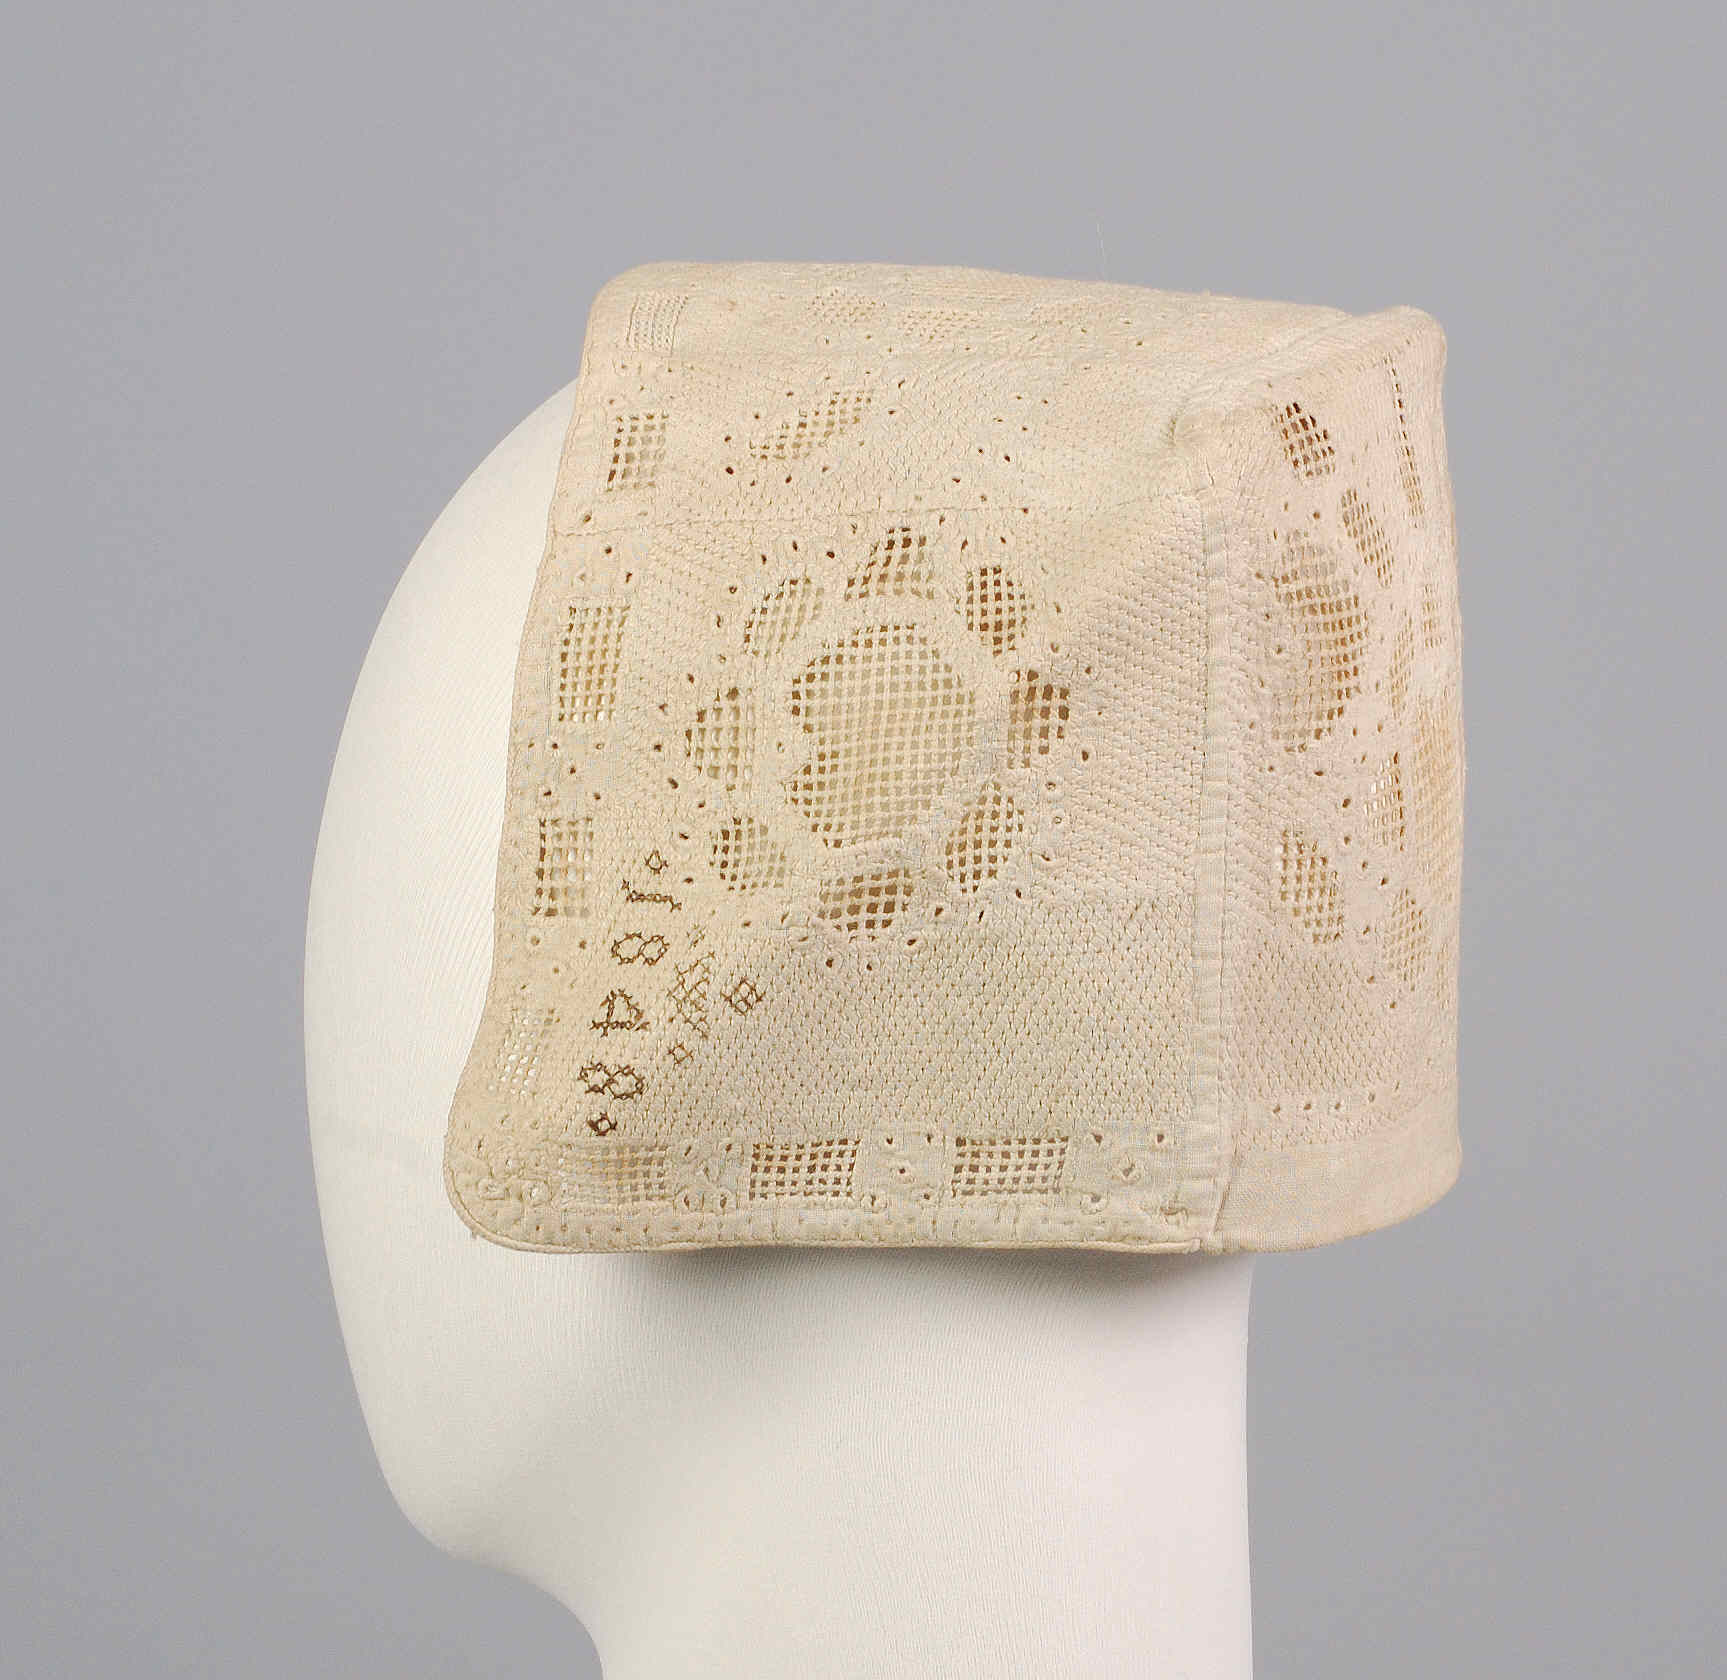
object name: cap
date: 1848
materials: linen